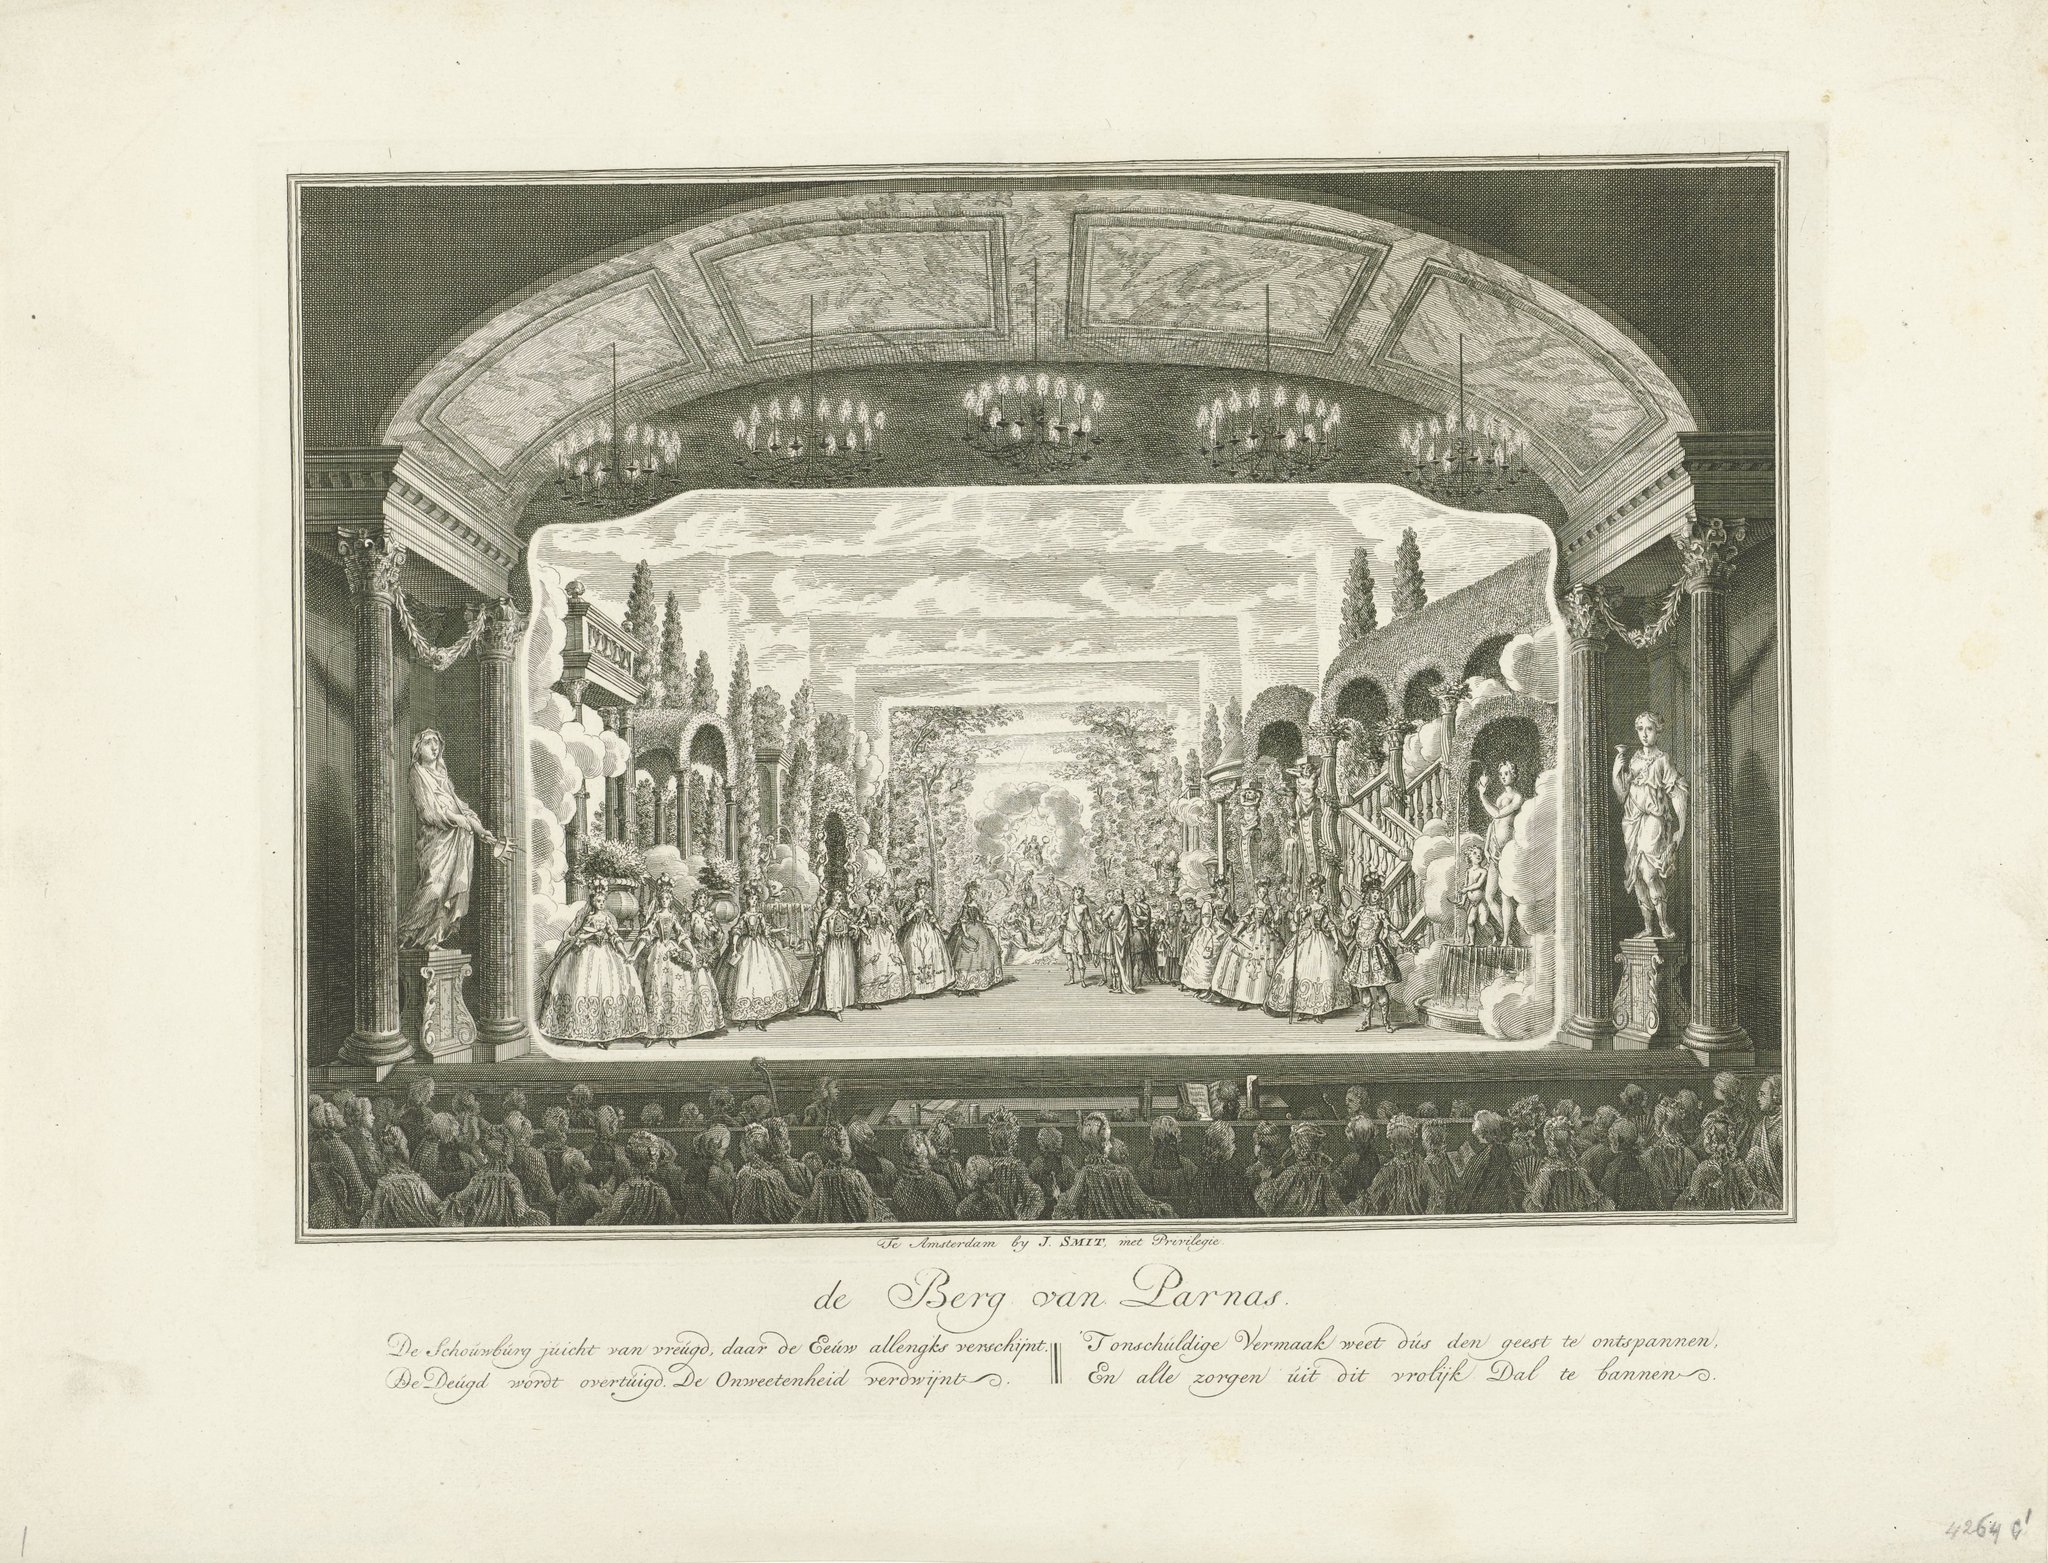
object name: print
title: de Berg van Parnas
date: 1738-1740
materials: paper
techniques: engraving, etching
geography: amsterdam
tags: theatre, theatrical performance, stage design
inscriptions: collector's mark: Lugt 2228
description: Toneelvoorstelling in de Amsterdamse Schouwburg op de Keizersgracht met het coulissendecor De Berg van Parnas met scène uit: Het Eeuwgetijde van den Amsteldamschen Schouwburg. Het decor gedrukt van een aparte plaat binnen een nieuw passe-partout met de zaal, orkestbak en de façade van het toneel met zuilen en kroonluchters. De titel en een vierregelig vers ook gedrukt van een aparte plaat. Onderdeel van een latere uitgave van de serie van 12 toneeldecors.